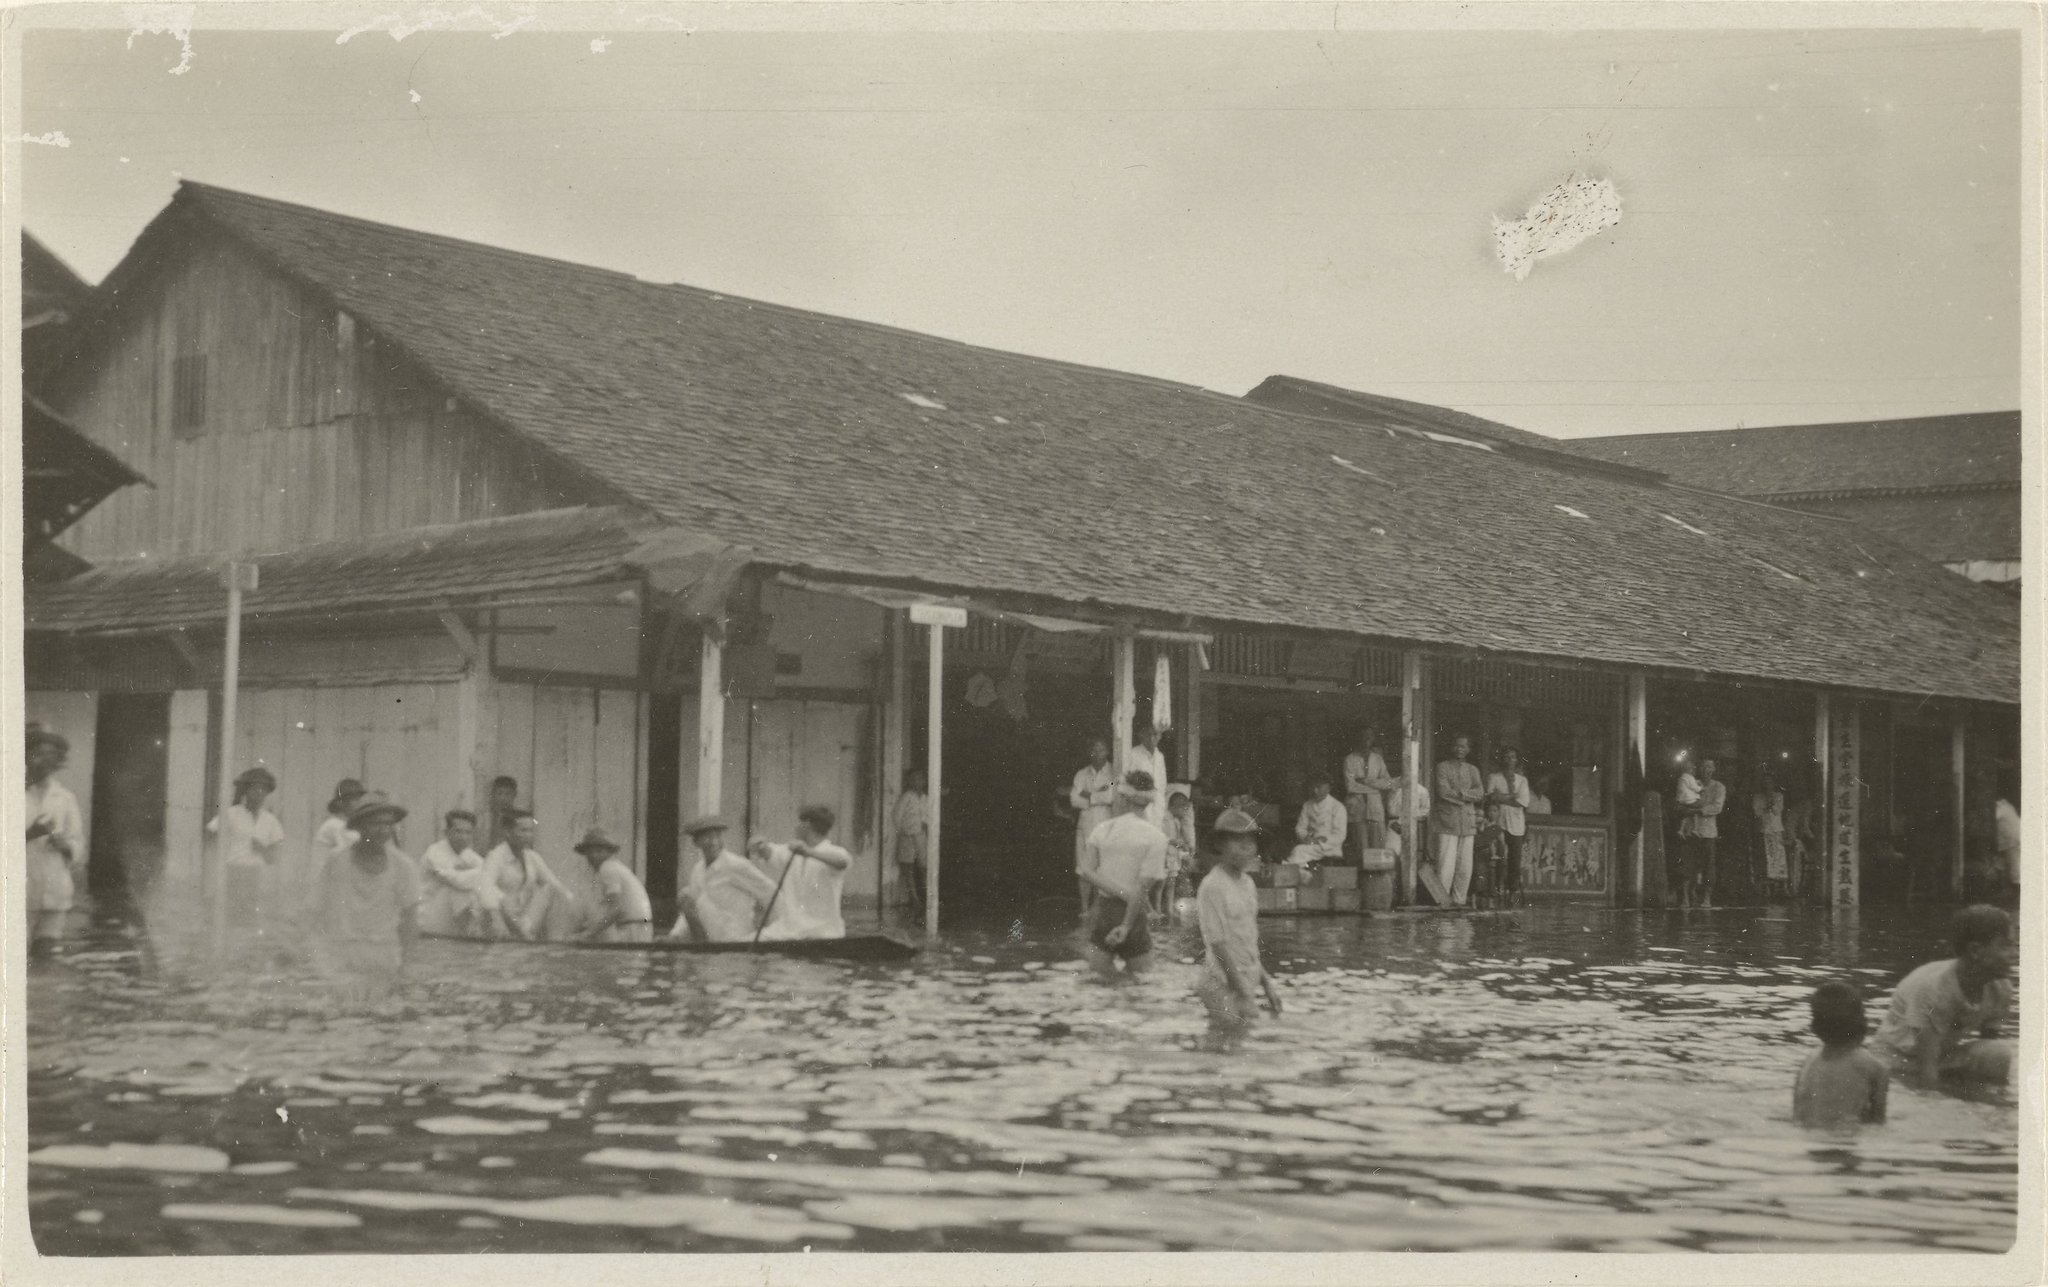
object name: photograph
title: Wateroverlast in Singkawang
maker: Anonymous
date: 1920-1940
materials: photographic support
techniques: gelatin silver print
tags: borneo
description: Onder water gelopen straat en pasar in Singkawang